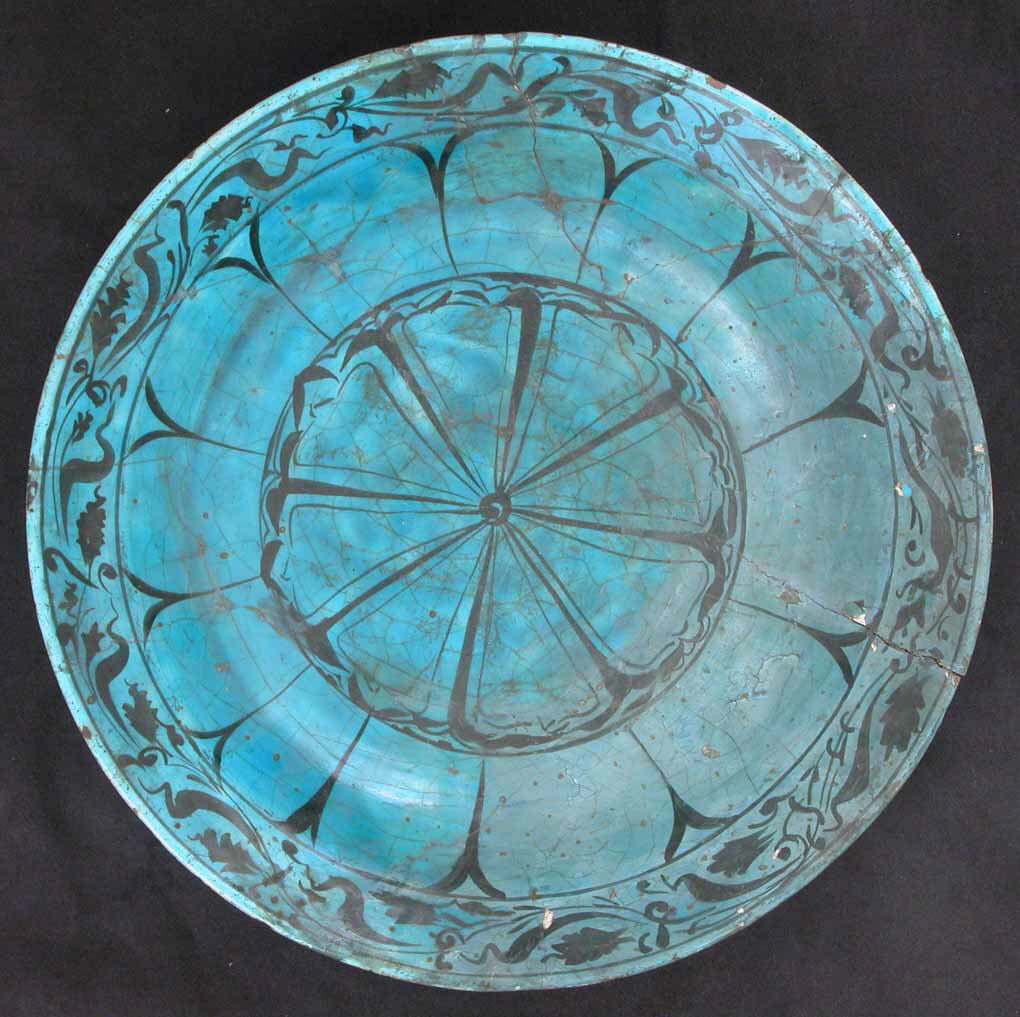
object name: dish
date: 1601-1700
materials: glaze, stonepaste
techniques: painting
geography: iran